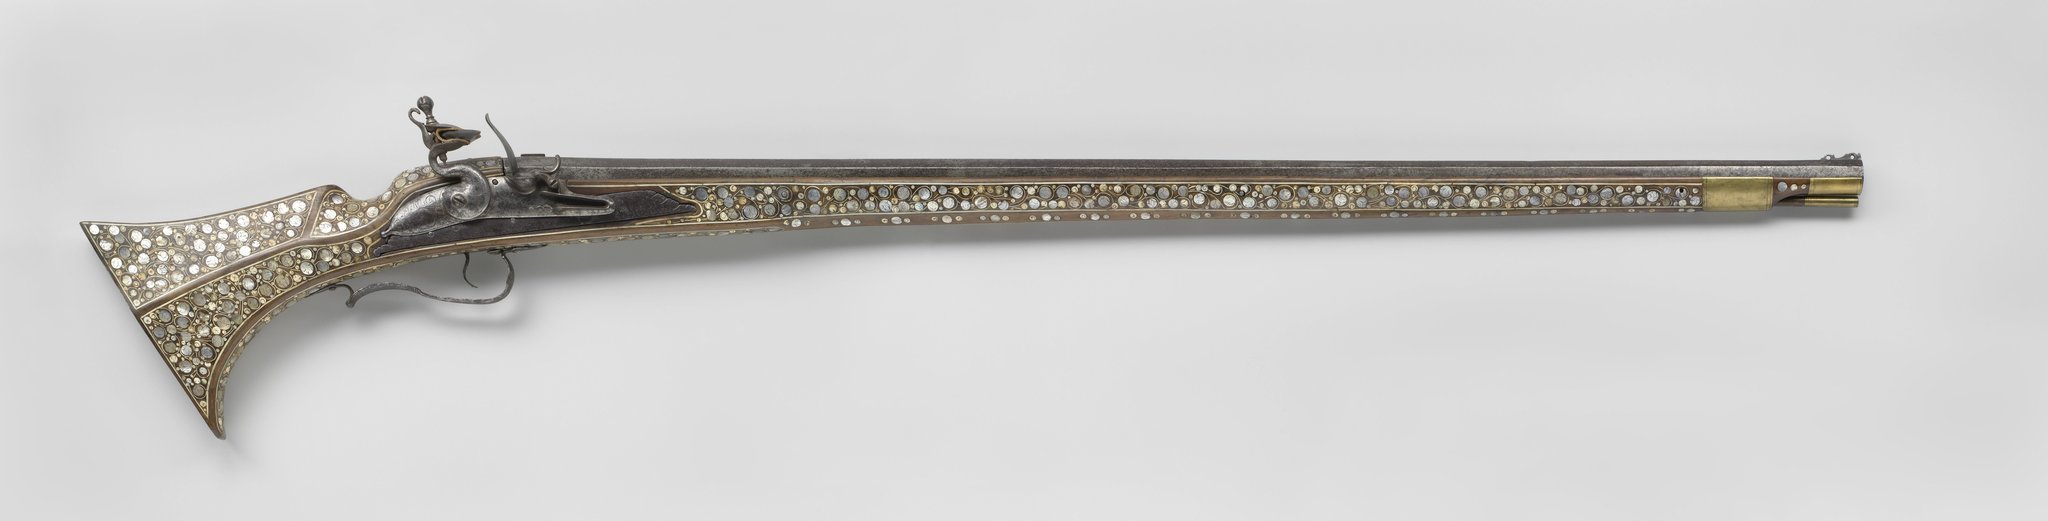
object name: lontslotwapen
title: Lontslotmusket met vuursteenslot uit latere periode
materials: brass, horn, iron, mother of pearl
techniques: embroidery, engraving, gilding, inlay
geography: utrecht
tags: ornament derived from plant forms, netherlands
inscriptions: signature: ‘BOWER’, mark: ‘AI; C’